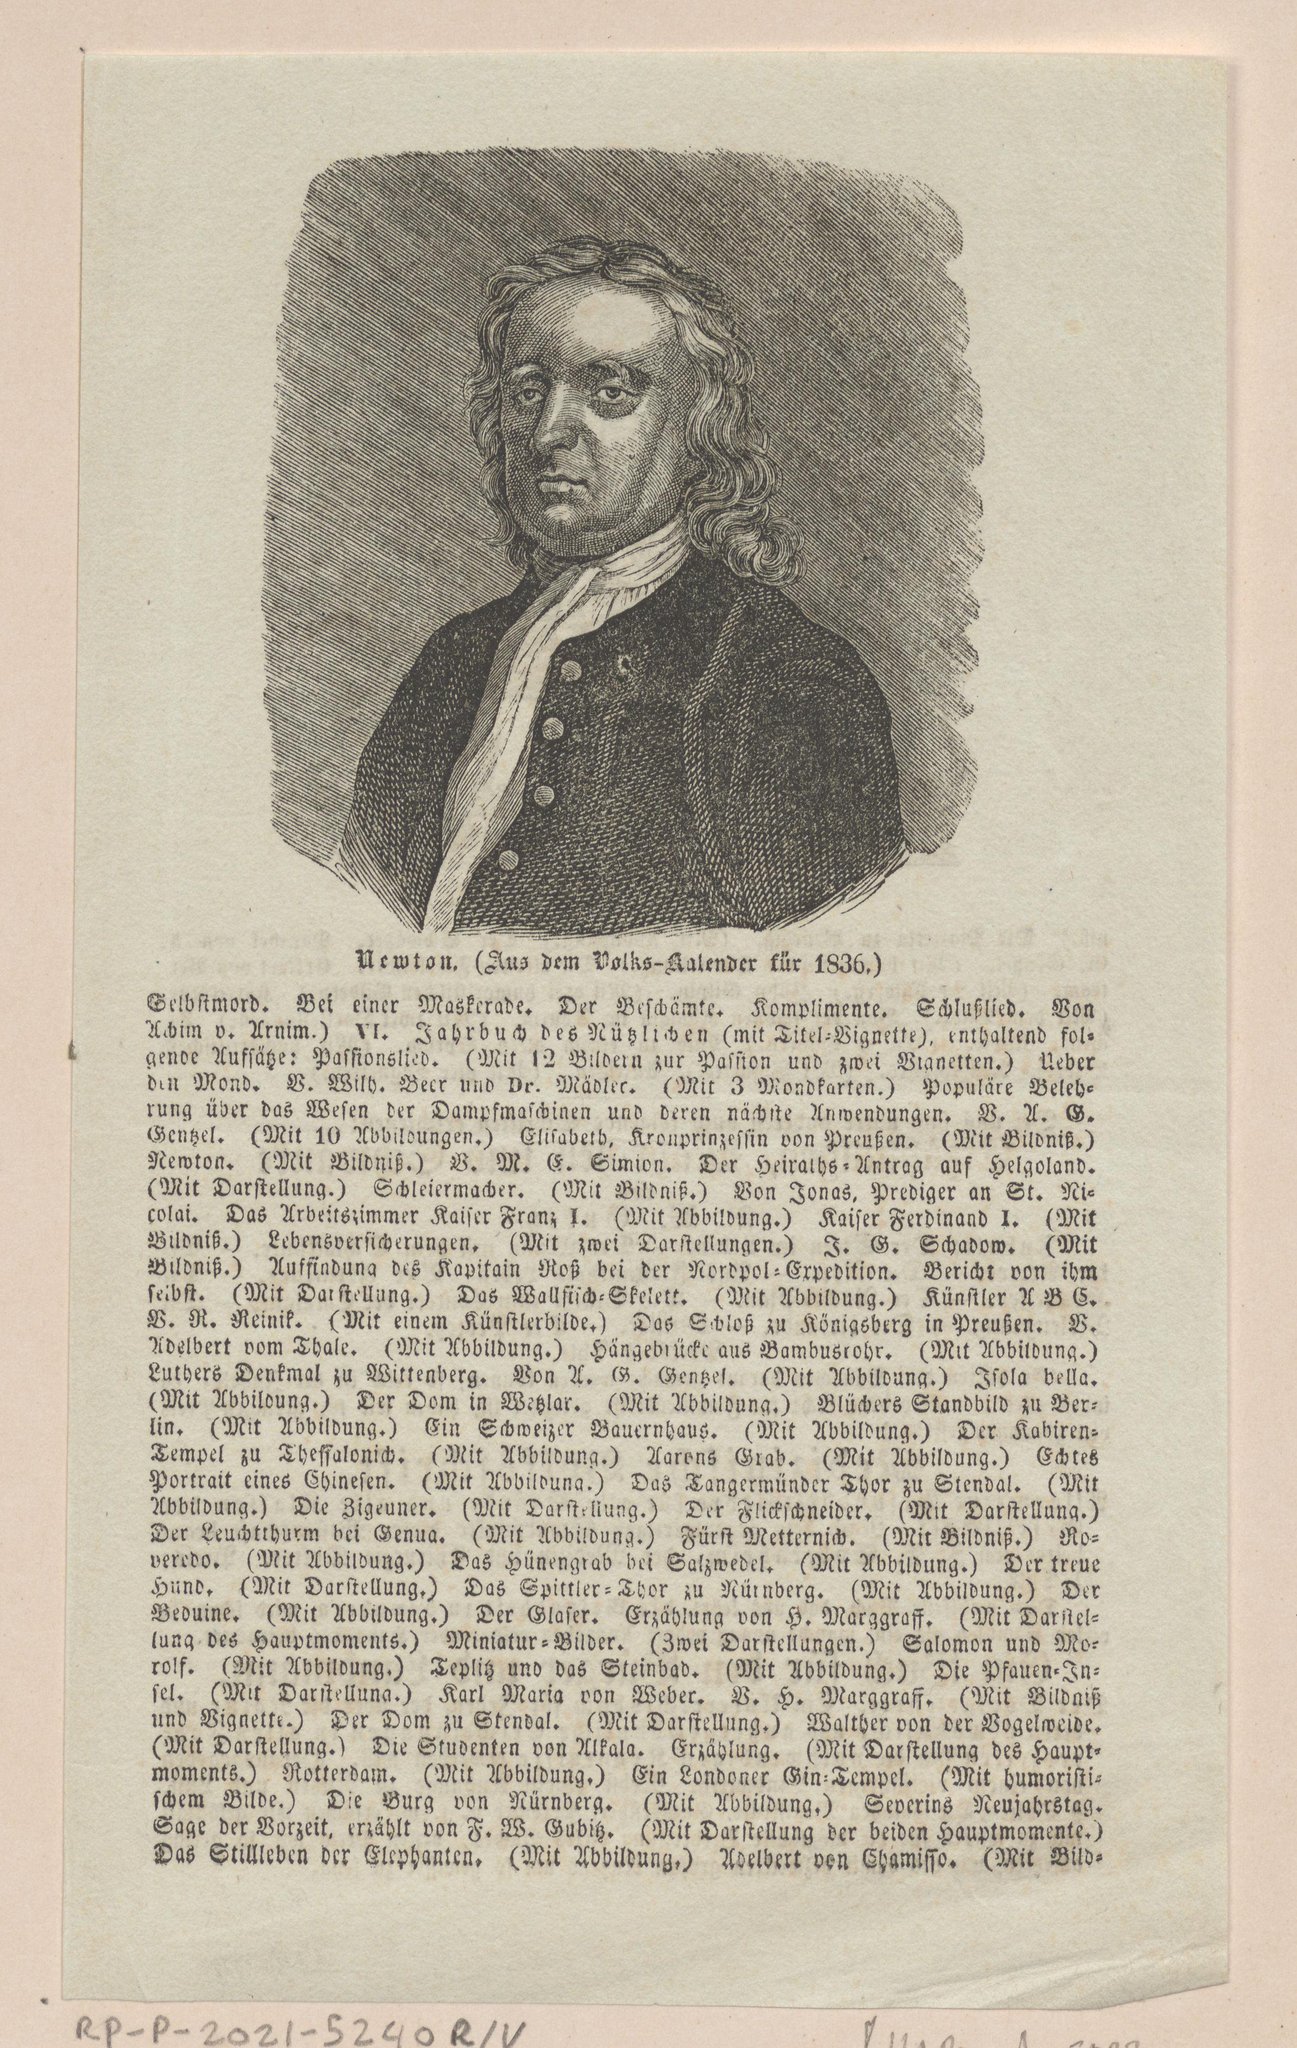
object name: print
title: Portret van Isaac Newton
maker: Anonymous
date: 1836-1850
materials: paper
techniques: letterpress printing, engraving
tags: london, physicist, historical persons, experiment, test ~ science and technology